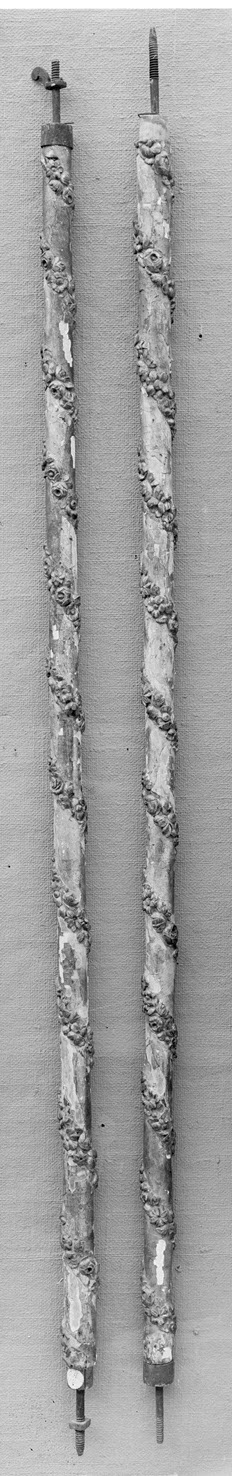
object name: bedpost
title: Pair of bedposts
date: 1701-1800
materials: gilt, wood